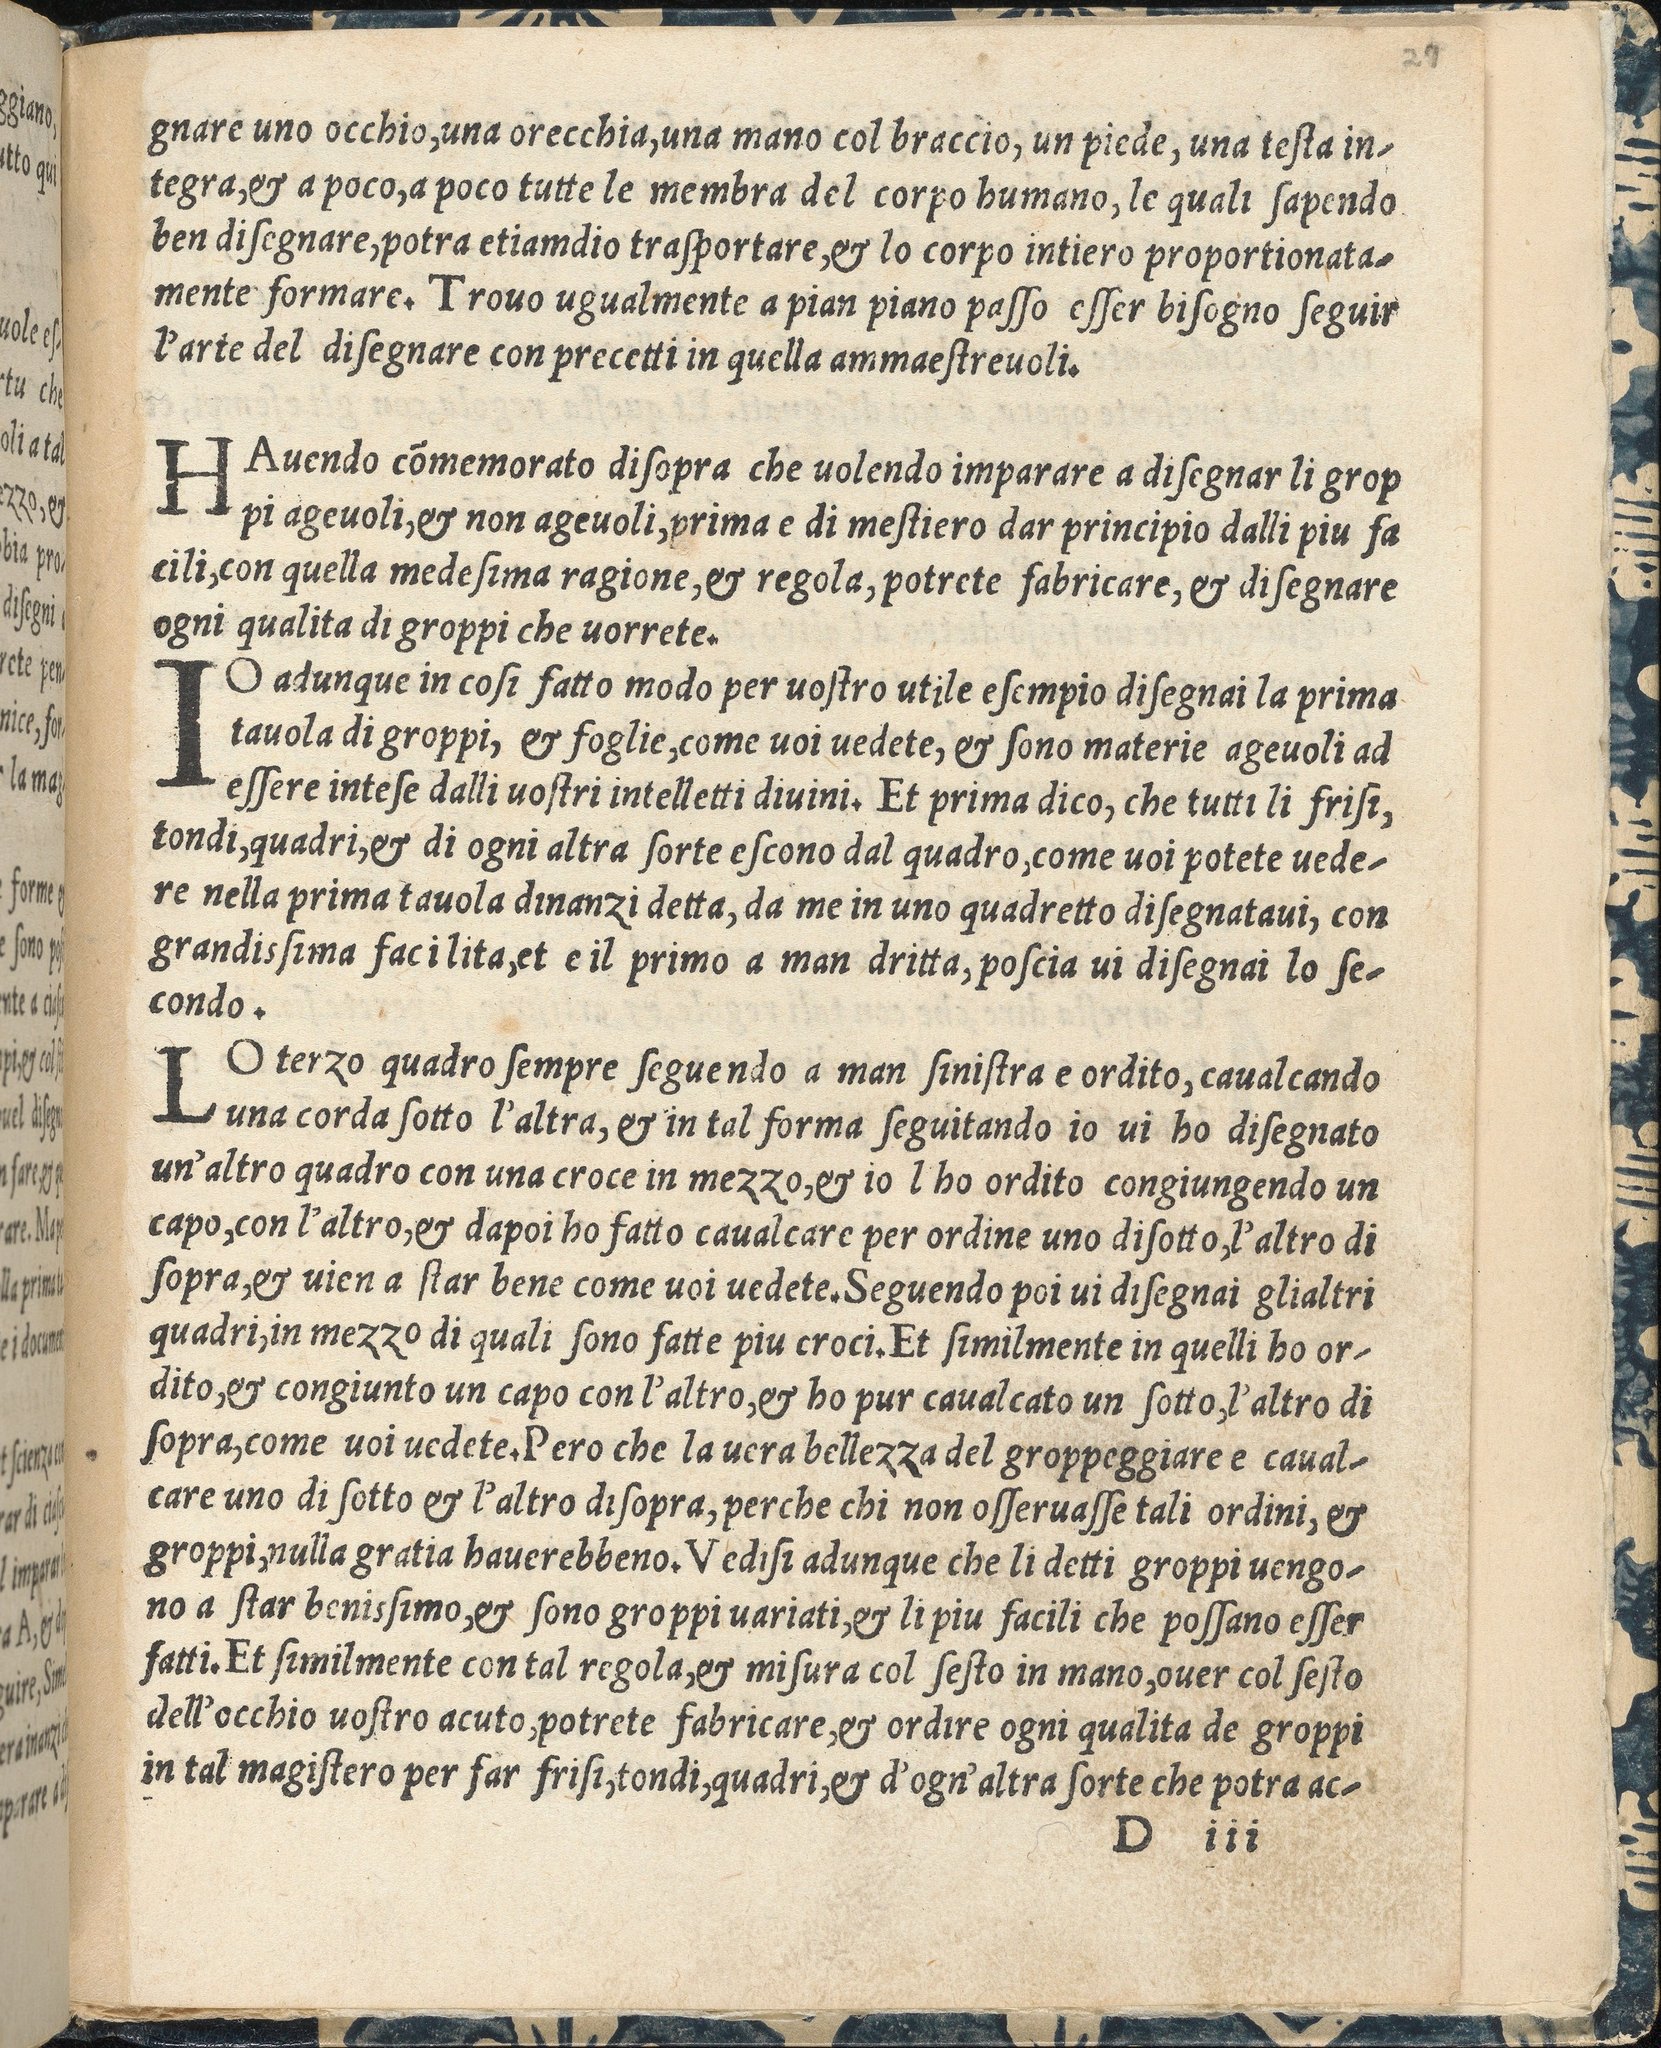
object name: book print ornament architecture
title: Essempio di recammi, page 27 (recto)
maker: giovanni antonio tagliente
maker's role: author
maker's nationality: italian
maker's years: 1465-1528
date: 1530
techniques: woodcut